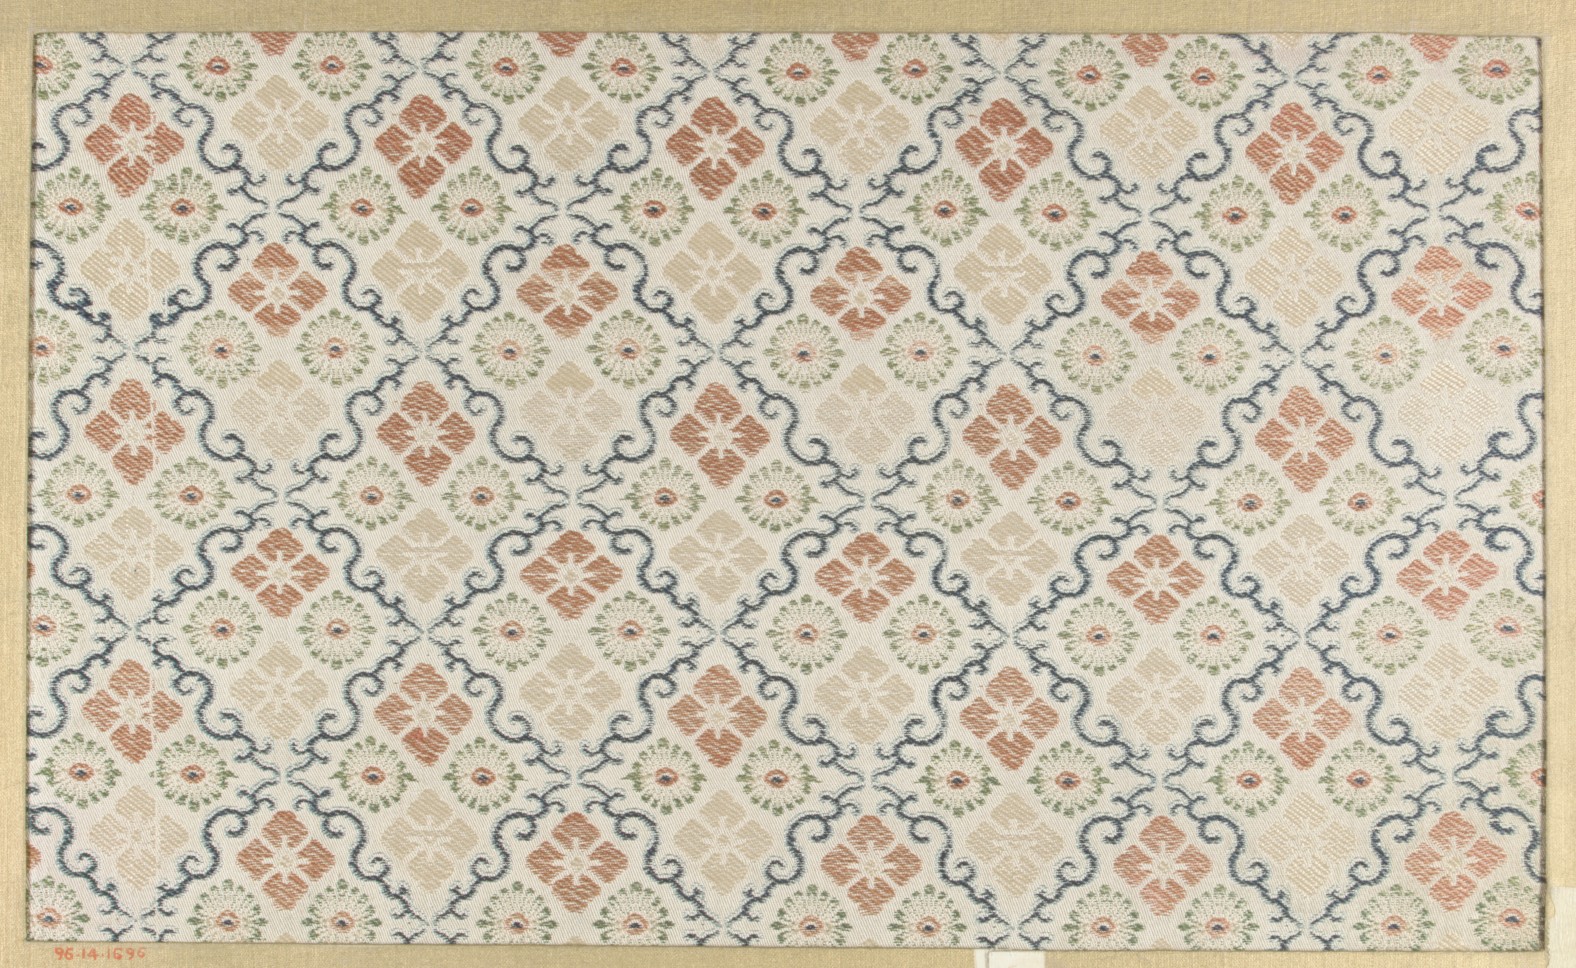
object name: piece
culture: japanese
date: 1701-1900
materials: silk